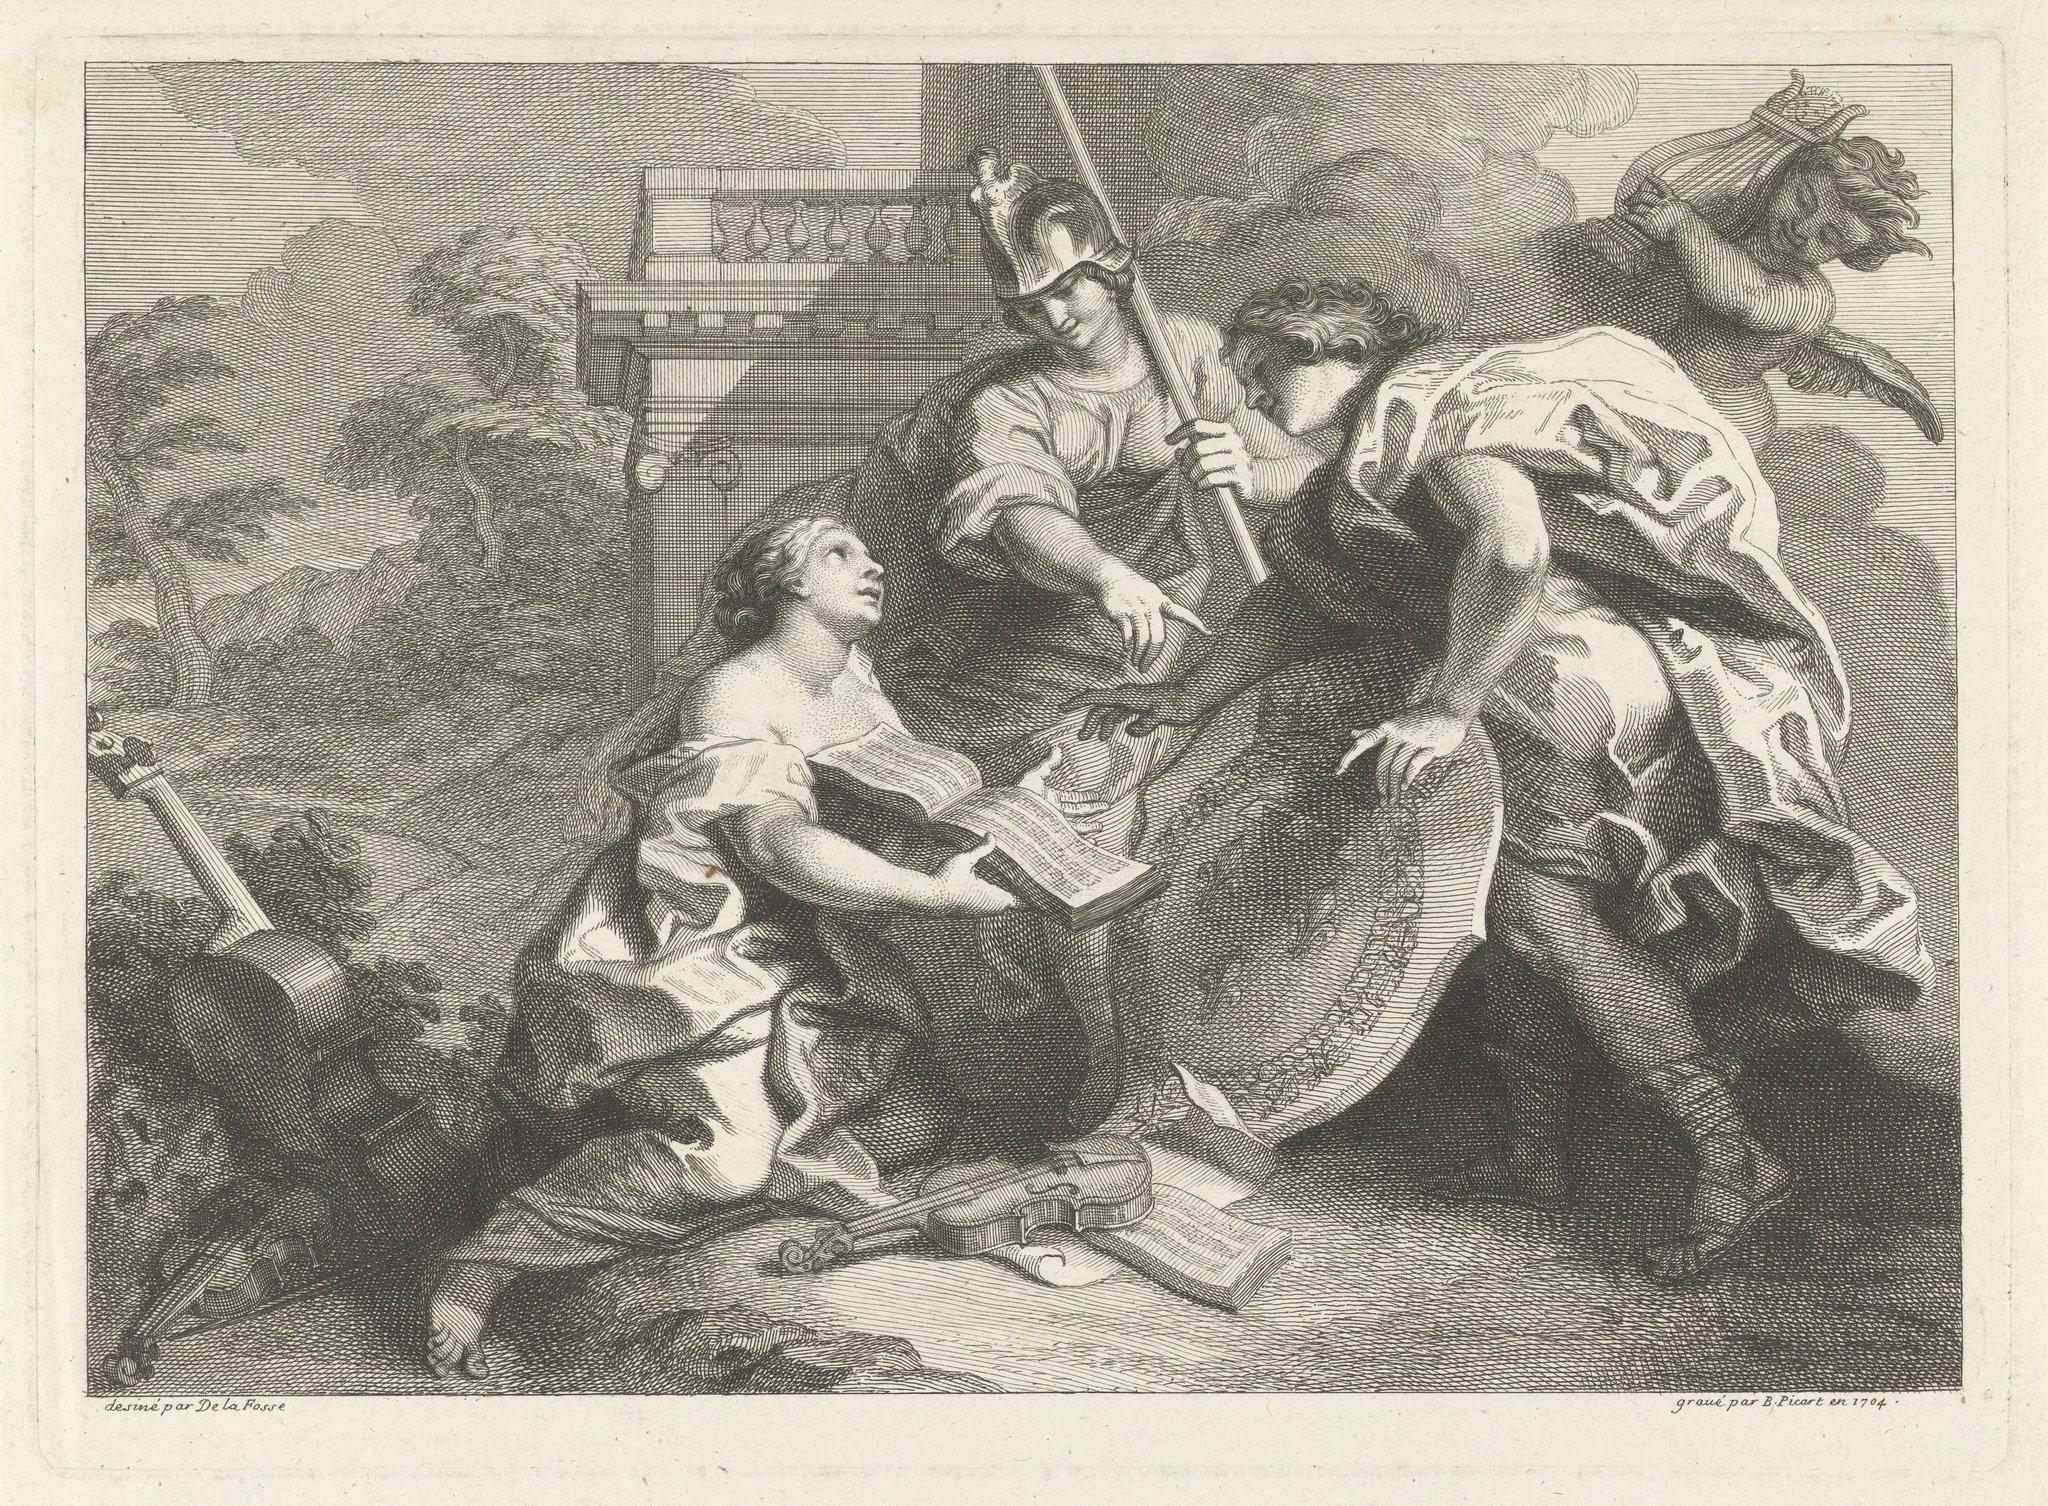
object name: print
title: Landschap met Gehoor(?)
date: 1704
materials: paper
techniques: engraving, etching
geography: paris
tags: filips ii (hertog van orléans), printed edition of musical score - cc - out of doors, hearing, listening (one of the five senses), music, lyre, cithara, psaltery, (story of) minerva (pallas, athena)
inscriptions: collector's mark: Lugt 240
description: Landschap met Gehoor(?), een opengeslagen liedboek in de hand. Aan haar voeten diverse strijkinstrumenten. Ze kijkt op naar een soldaat, die haar de hand reikt. Minerva wijst op het wapenschild van Filips II, hertog van Orléans. Op de achtergrond een putto met een lier in de hand.